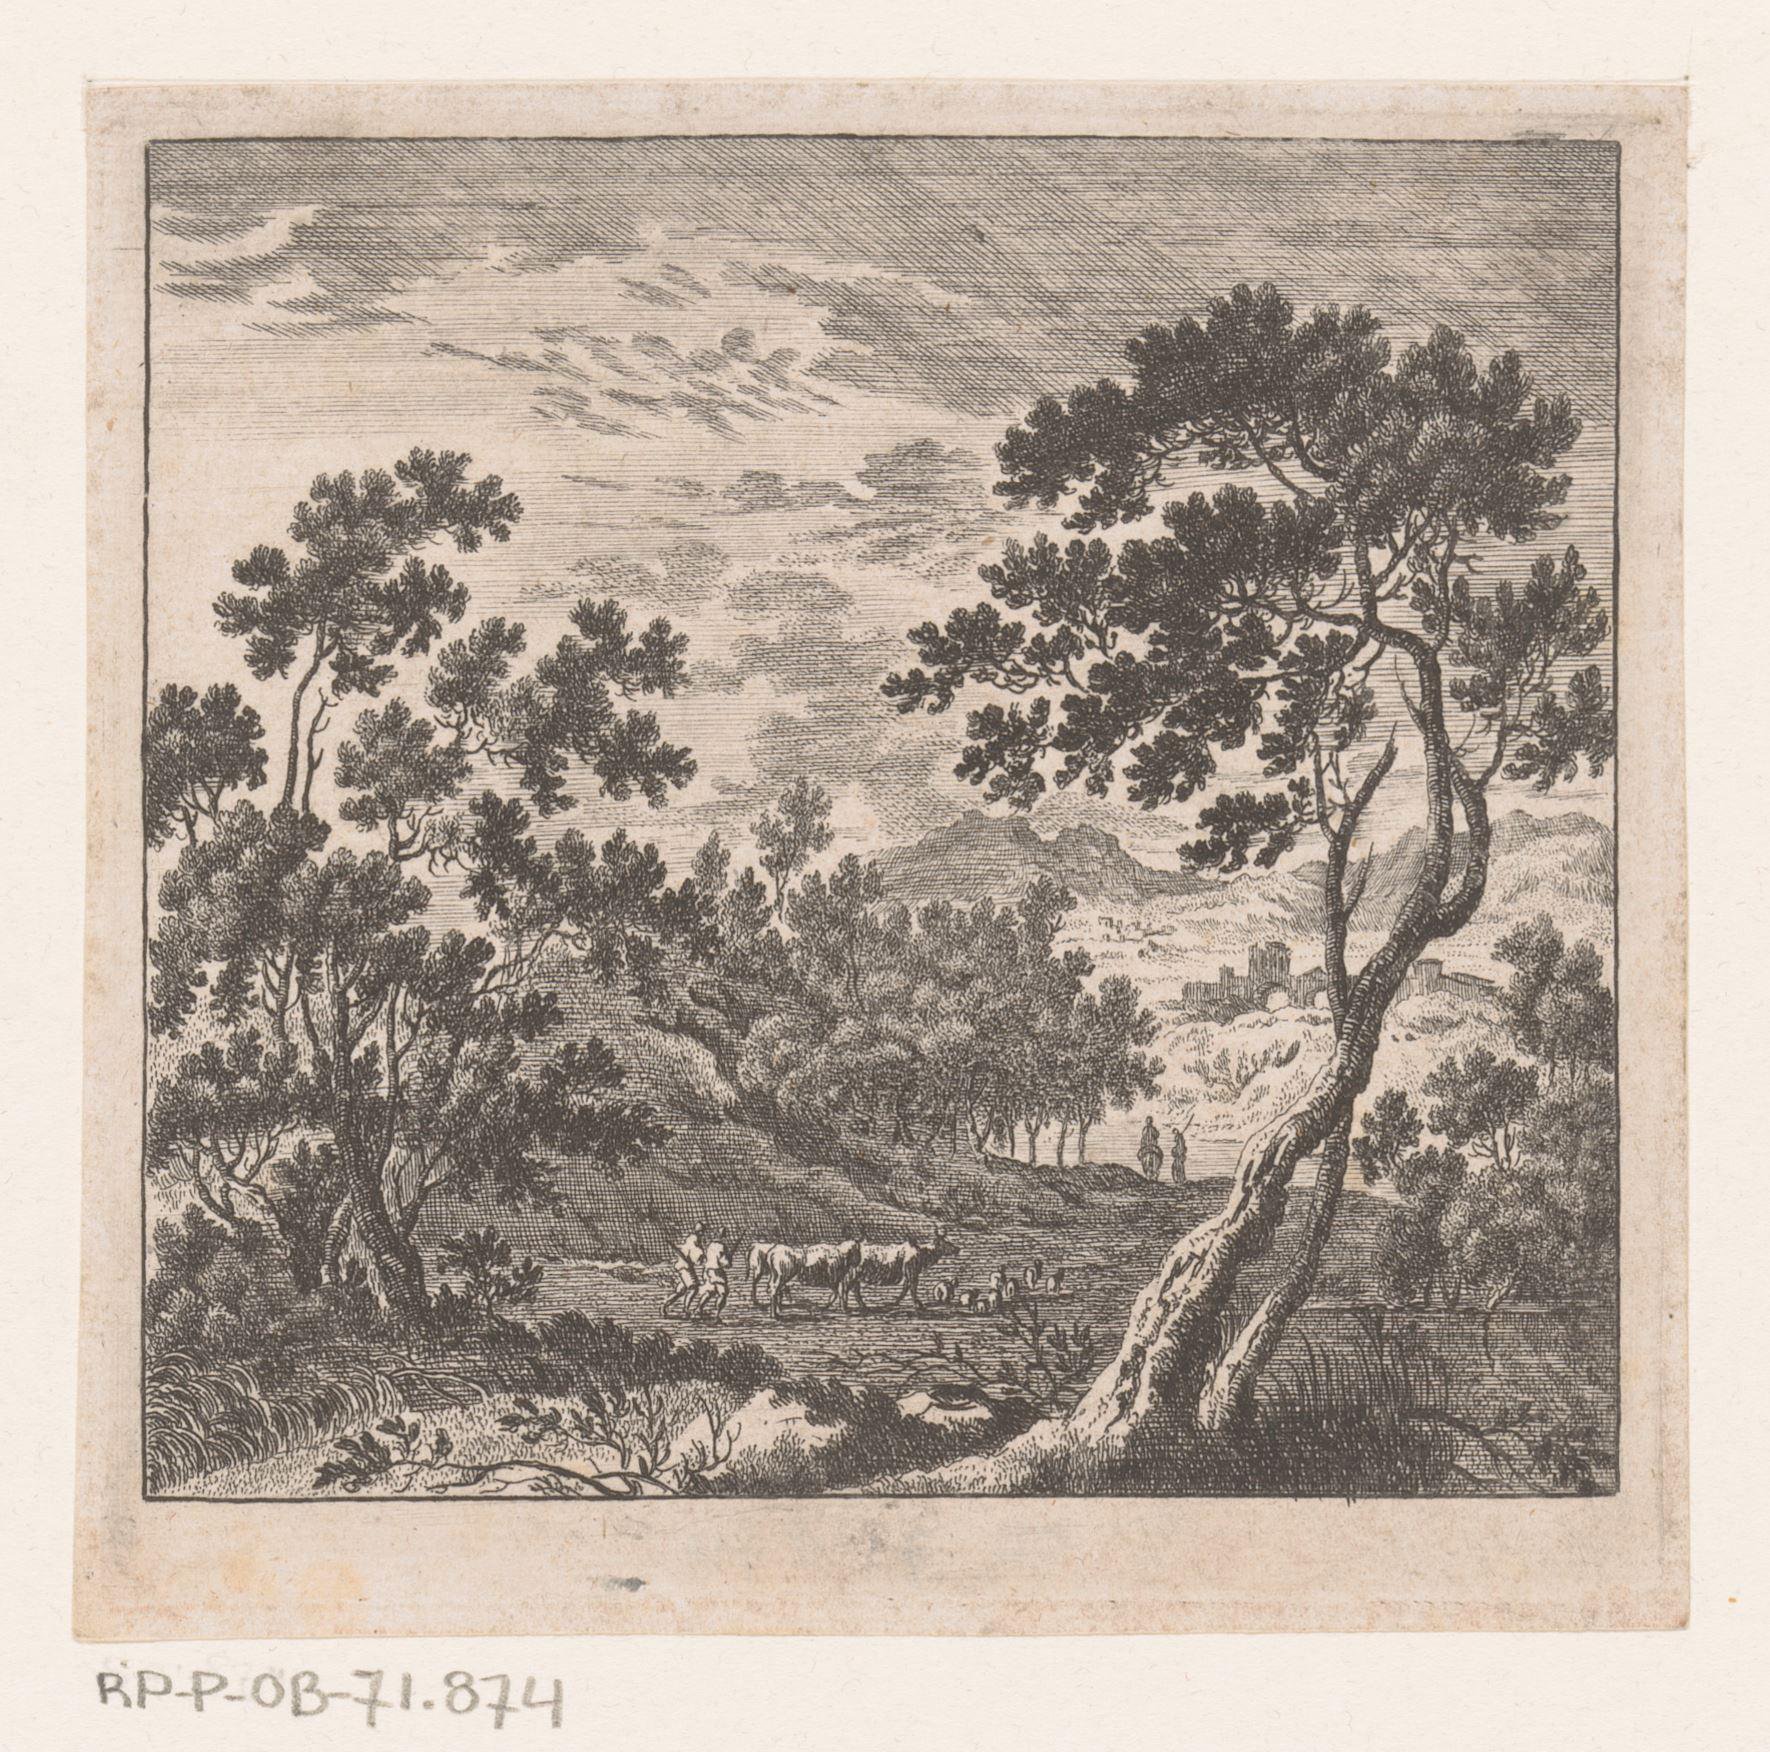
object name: print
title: Landschap met herders met kudde vee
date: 1613-1695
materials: paper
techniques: etching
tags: landscapes, herd, flock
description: Prenten met het signatuur 'Perelle' kunnen zowel door vader Gabriel als door zonen Nicolas en Adam gemaakt zijn.